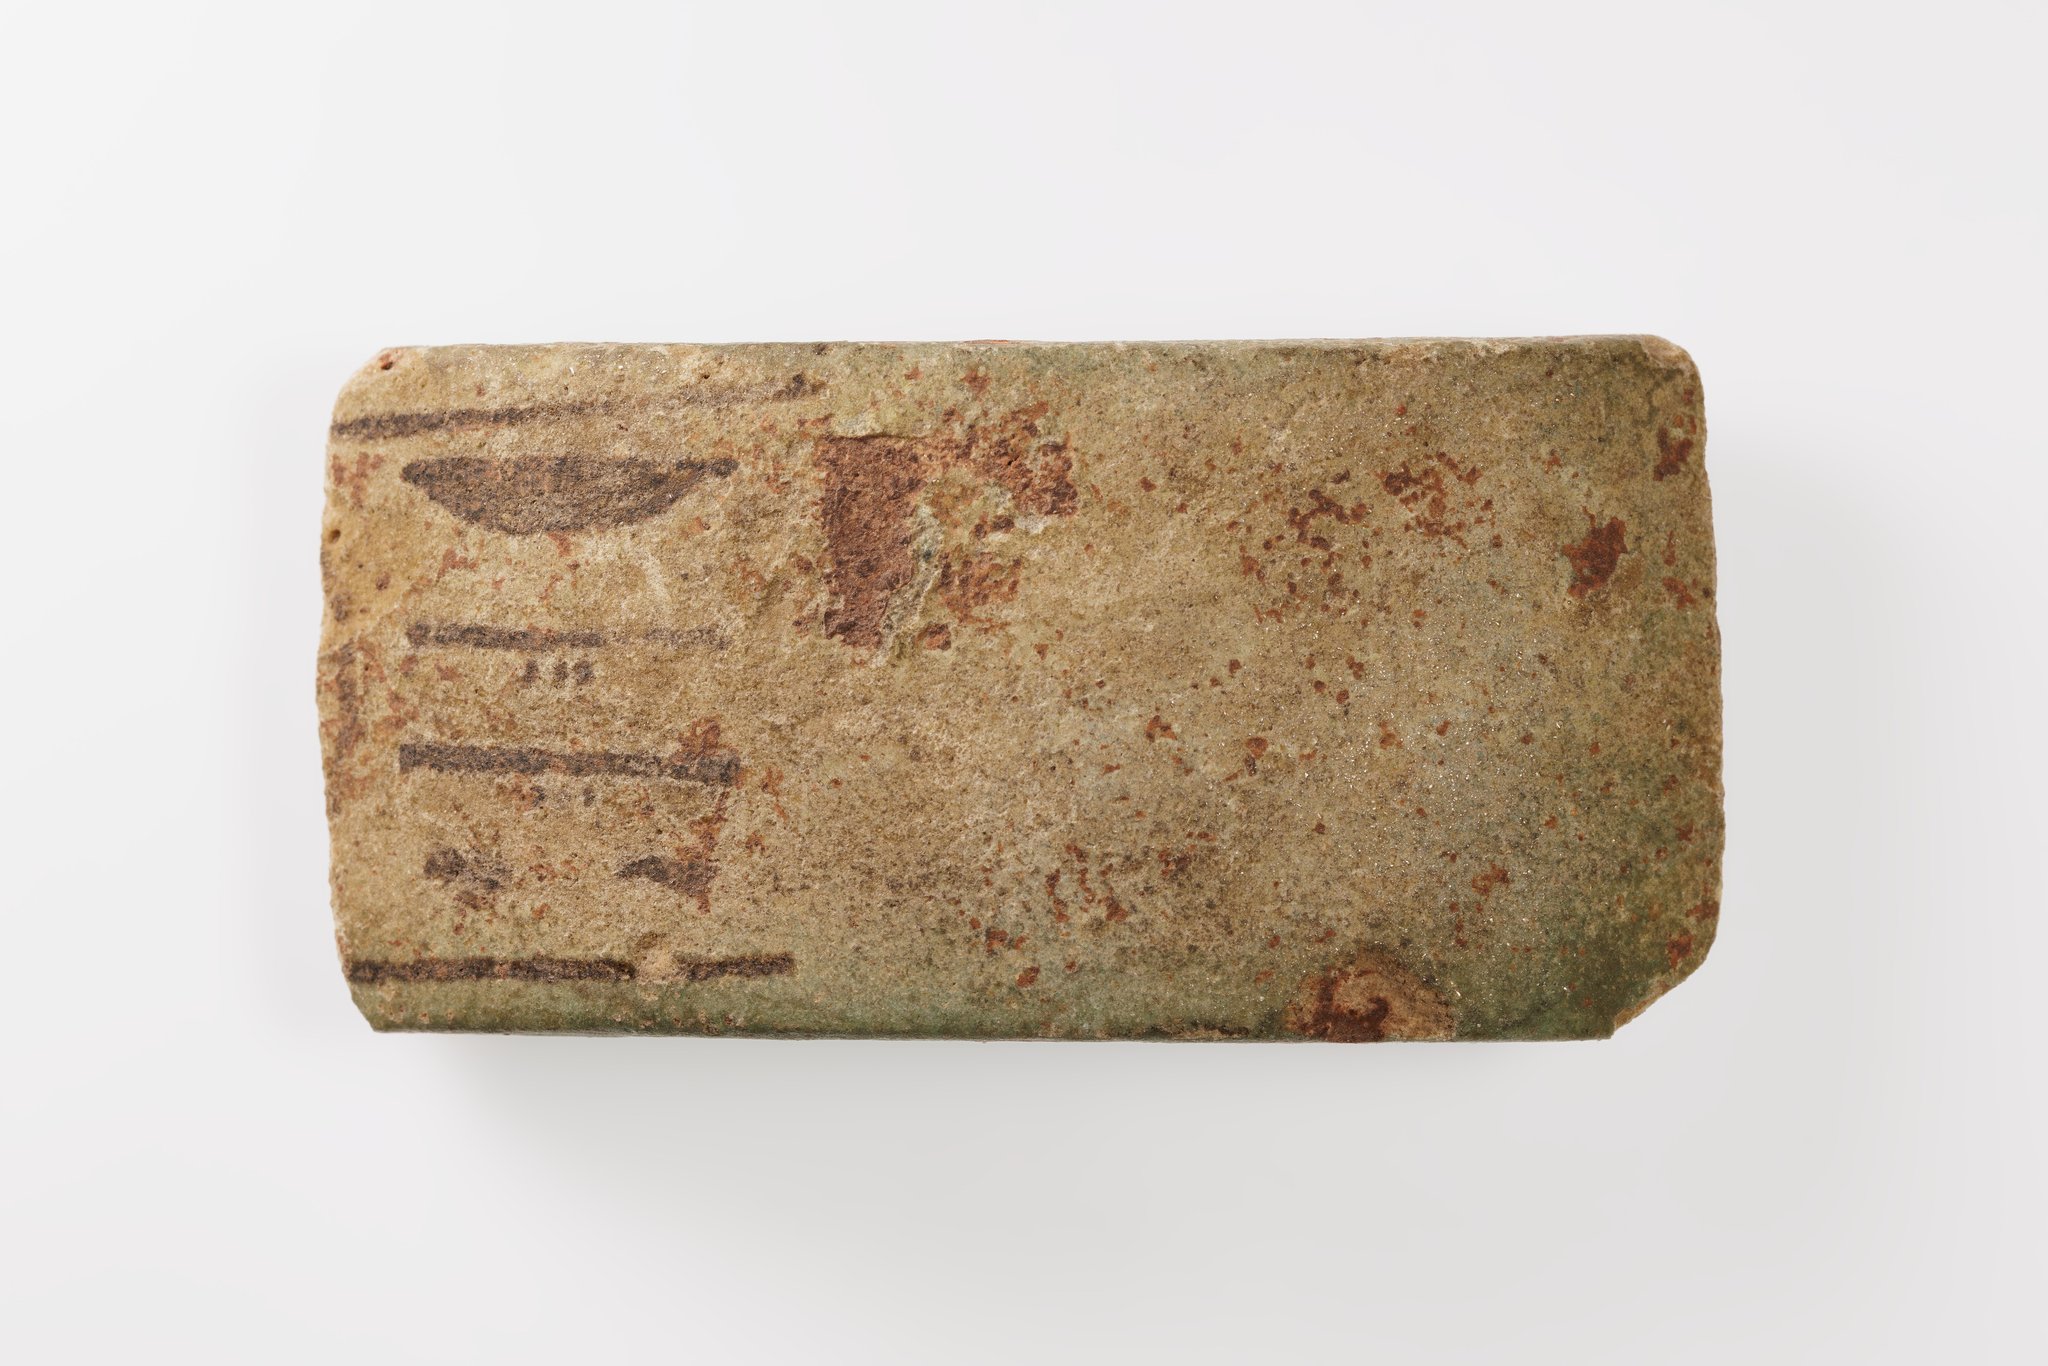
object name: votive bracelet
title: Fragment of a votive bracelet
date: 1295-1070 BCE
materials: faience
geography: egypt